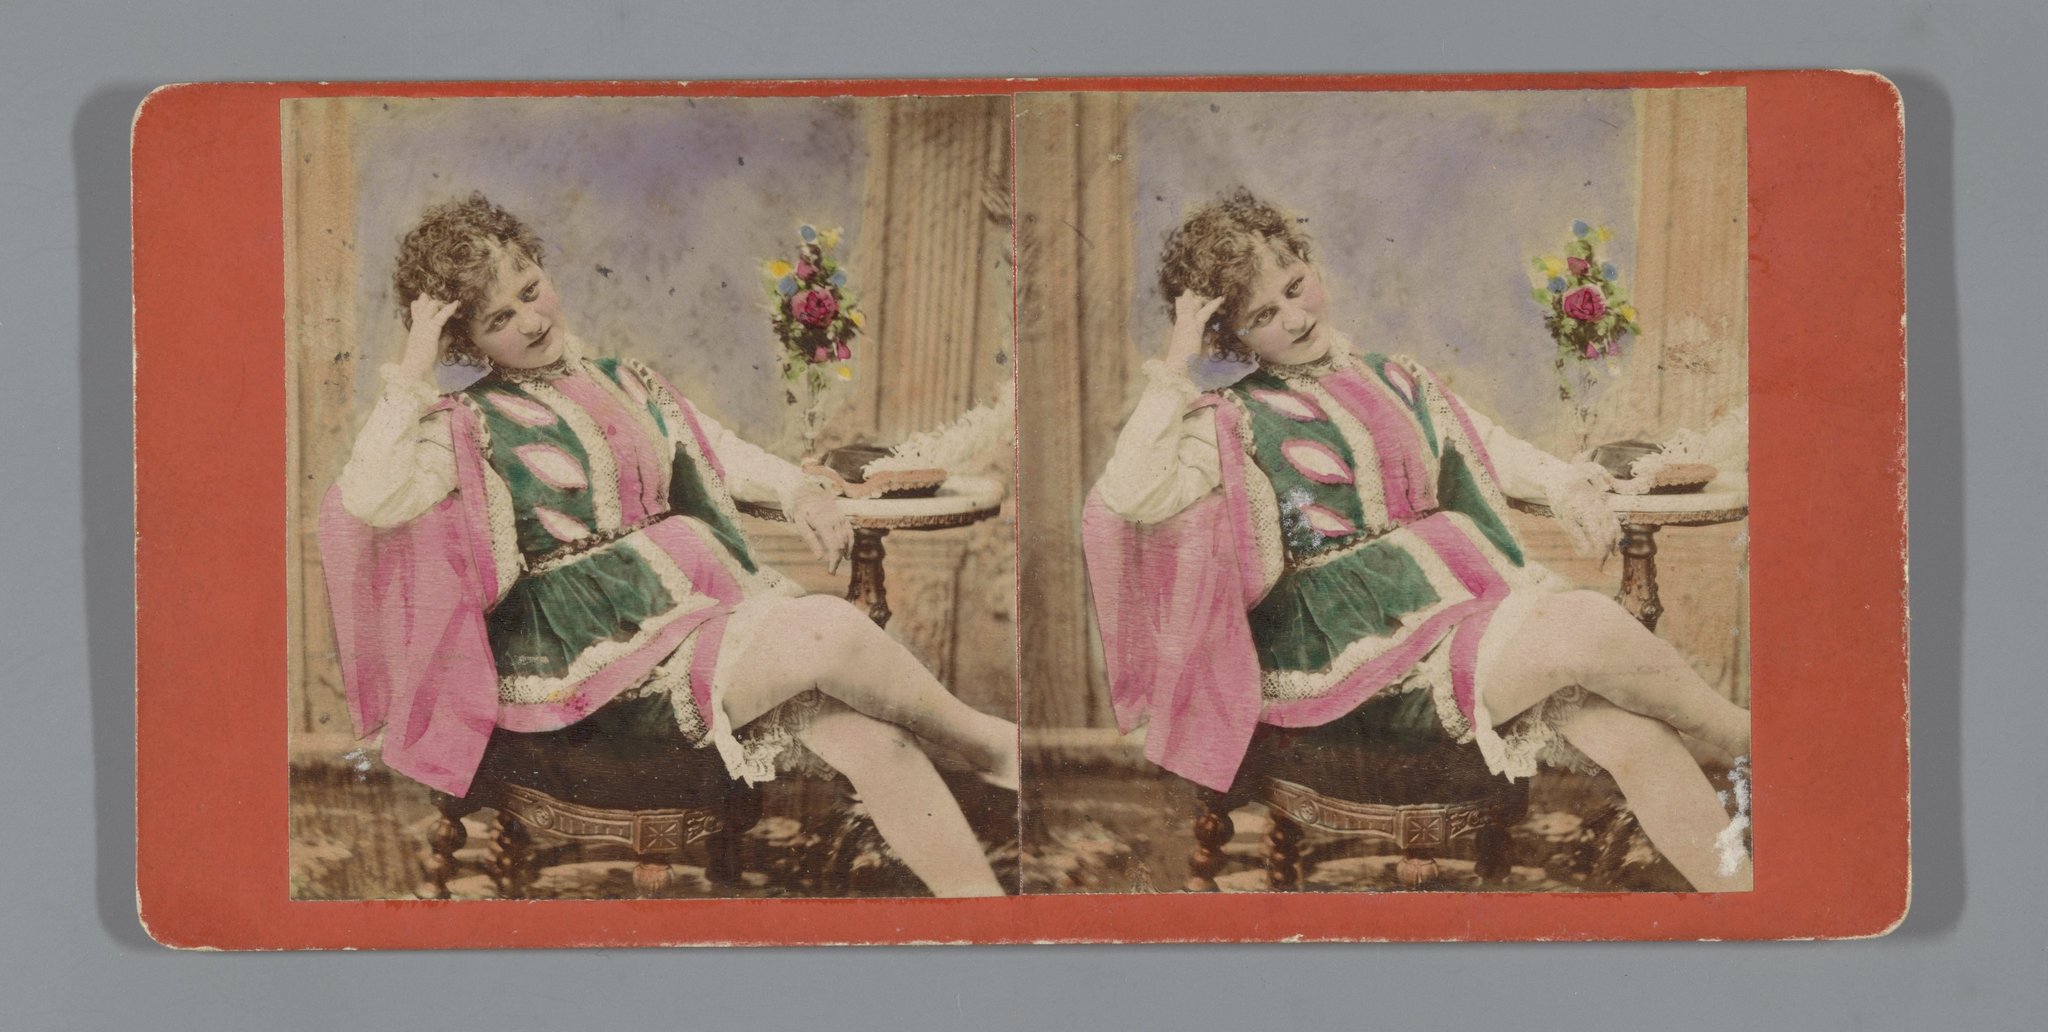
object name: stereograph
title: Vrouw op een stoel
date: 1868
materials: cardboard, paper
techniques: albumen print, hand coloring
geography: berlin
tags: adult woman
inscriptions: inscription: ‘264/17 1/2/ 65e’